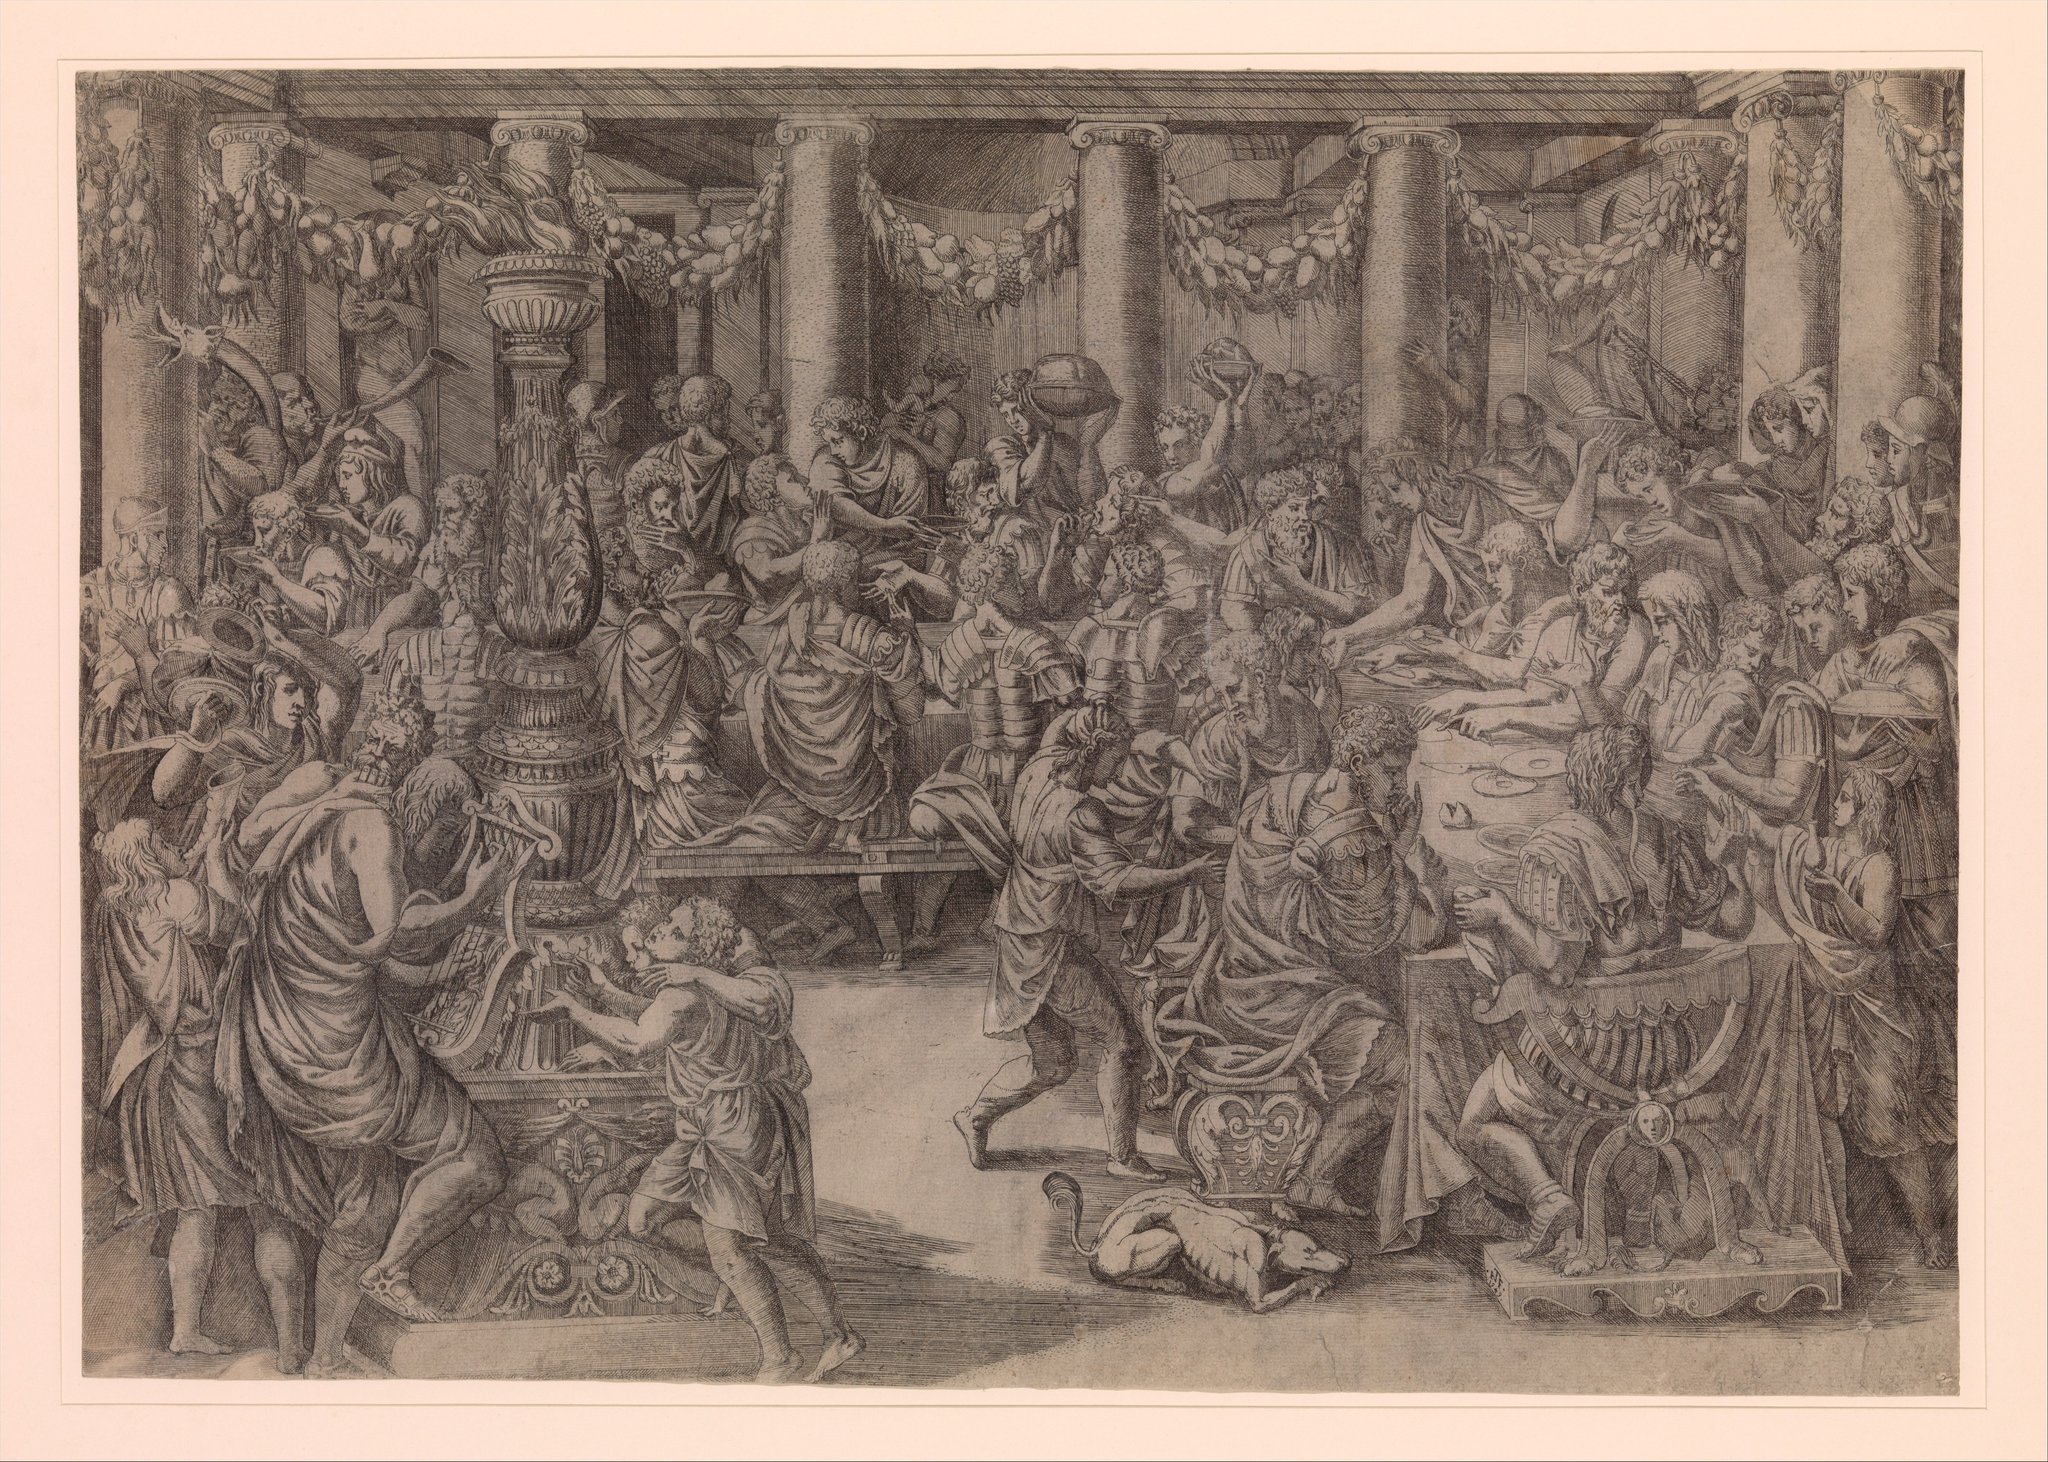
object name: print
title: Banquet of Scipio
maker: antonio fantuzzi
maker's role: artist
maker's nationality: italian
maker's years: 1537-1545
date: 1543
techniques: etching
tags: food,men,dining,musicians